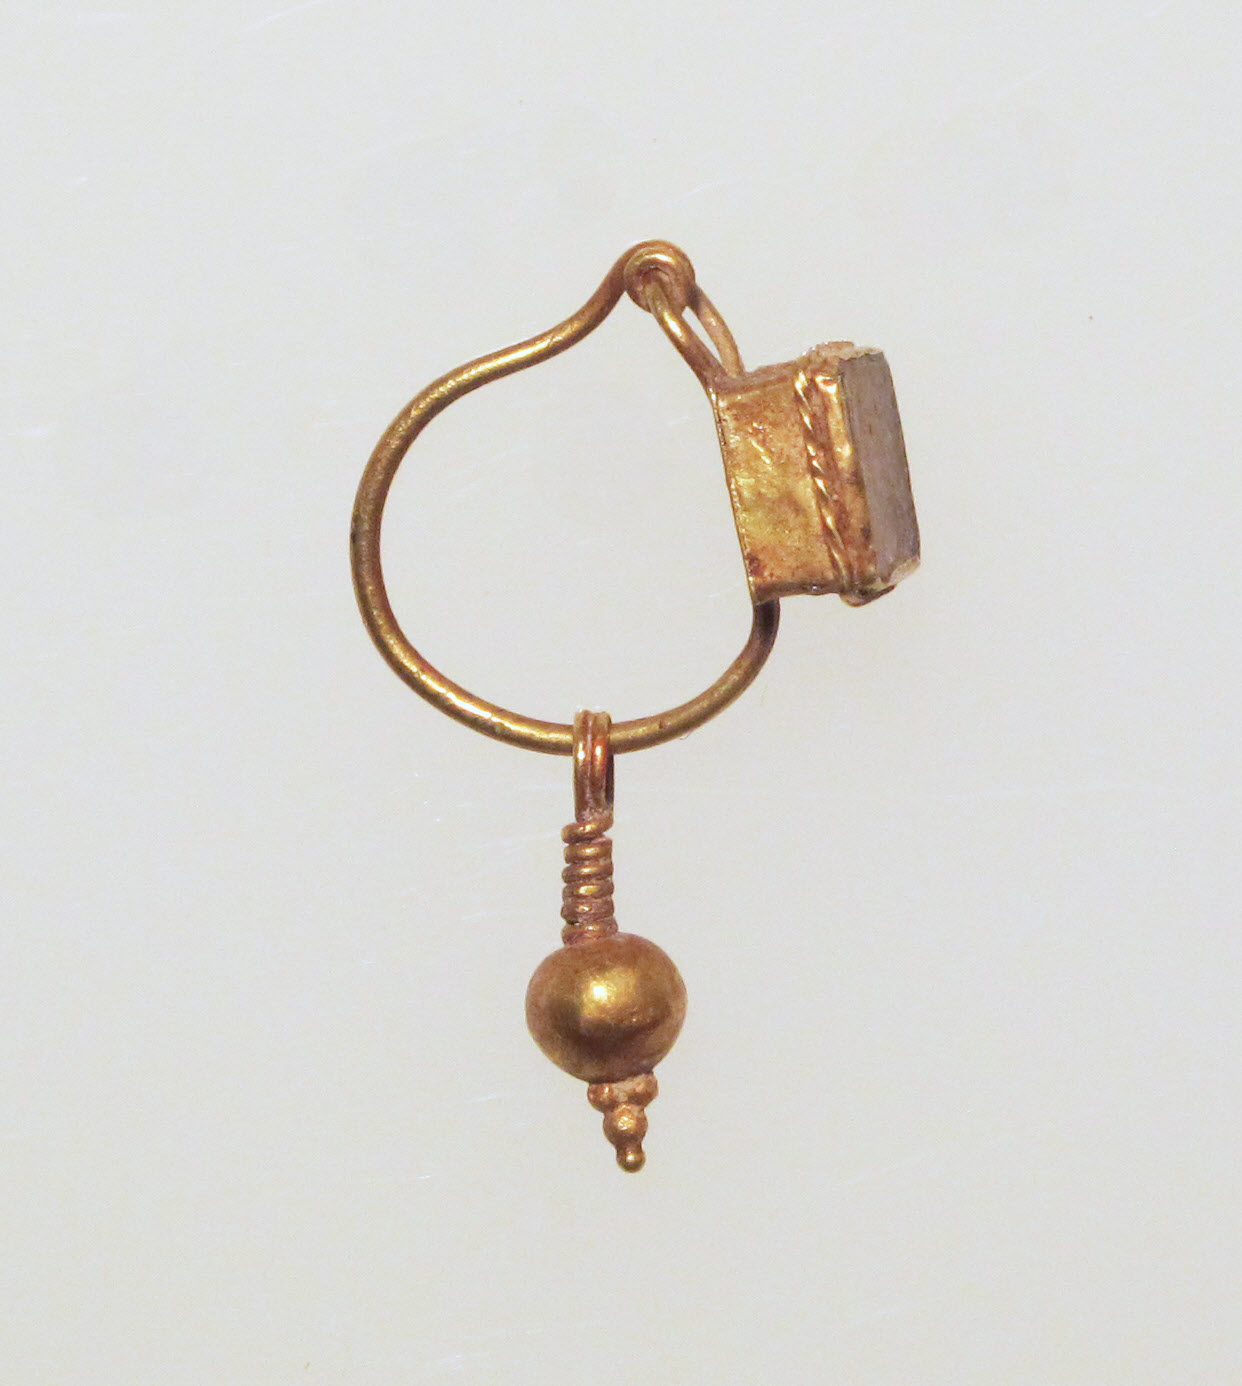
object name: earring with pendant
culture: roman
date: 670 BCE-330 CE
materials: gold